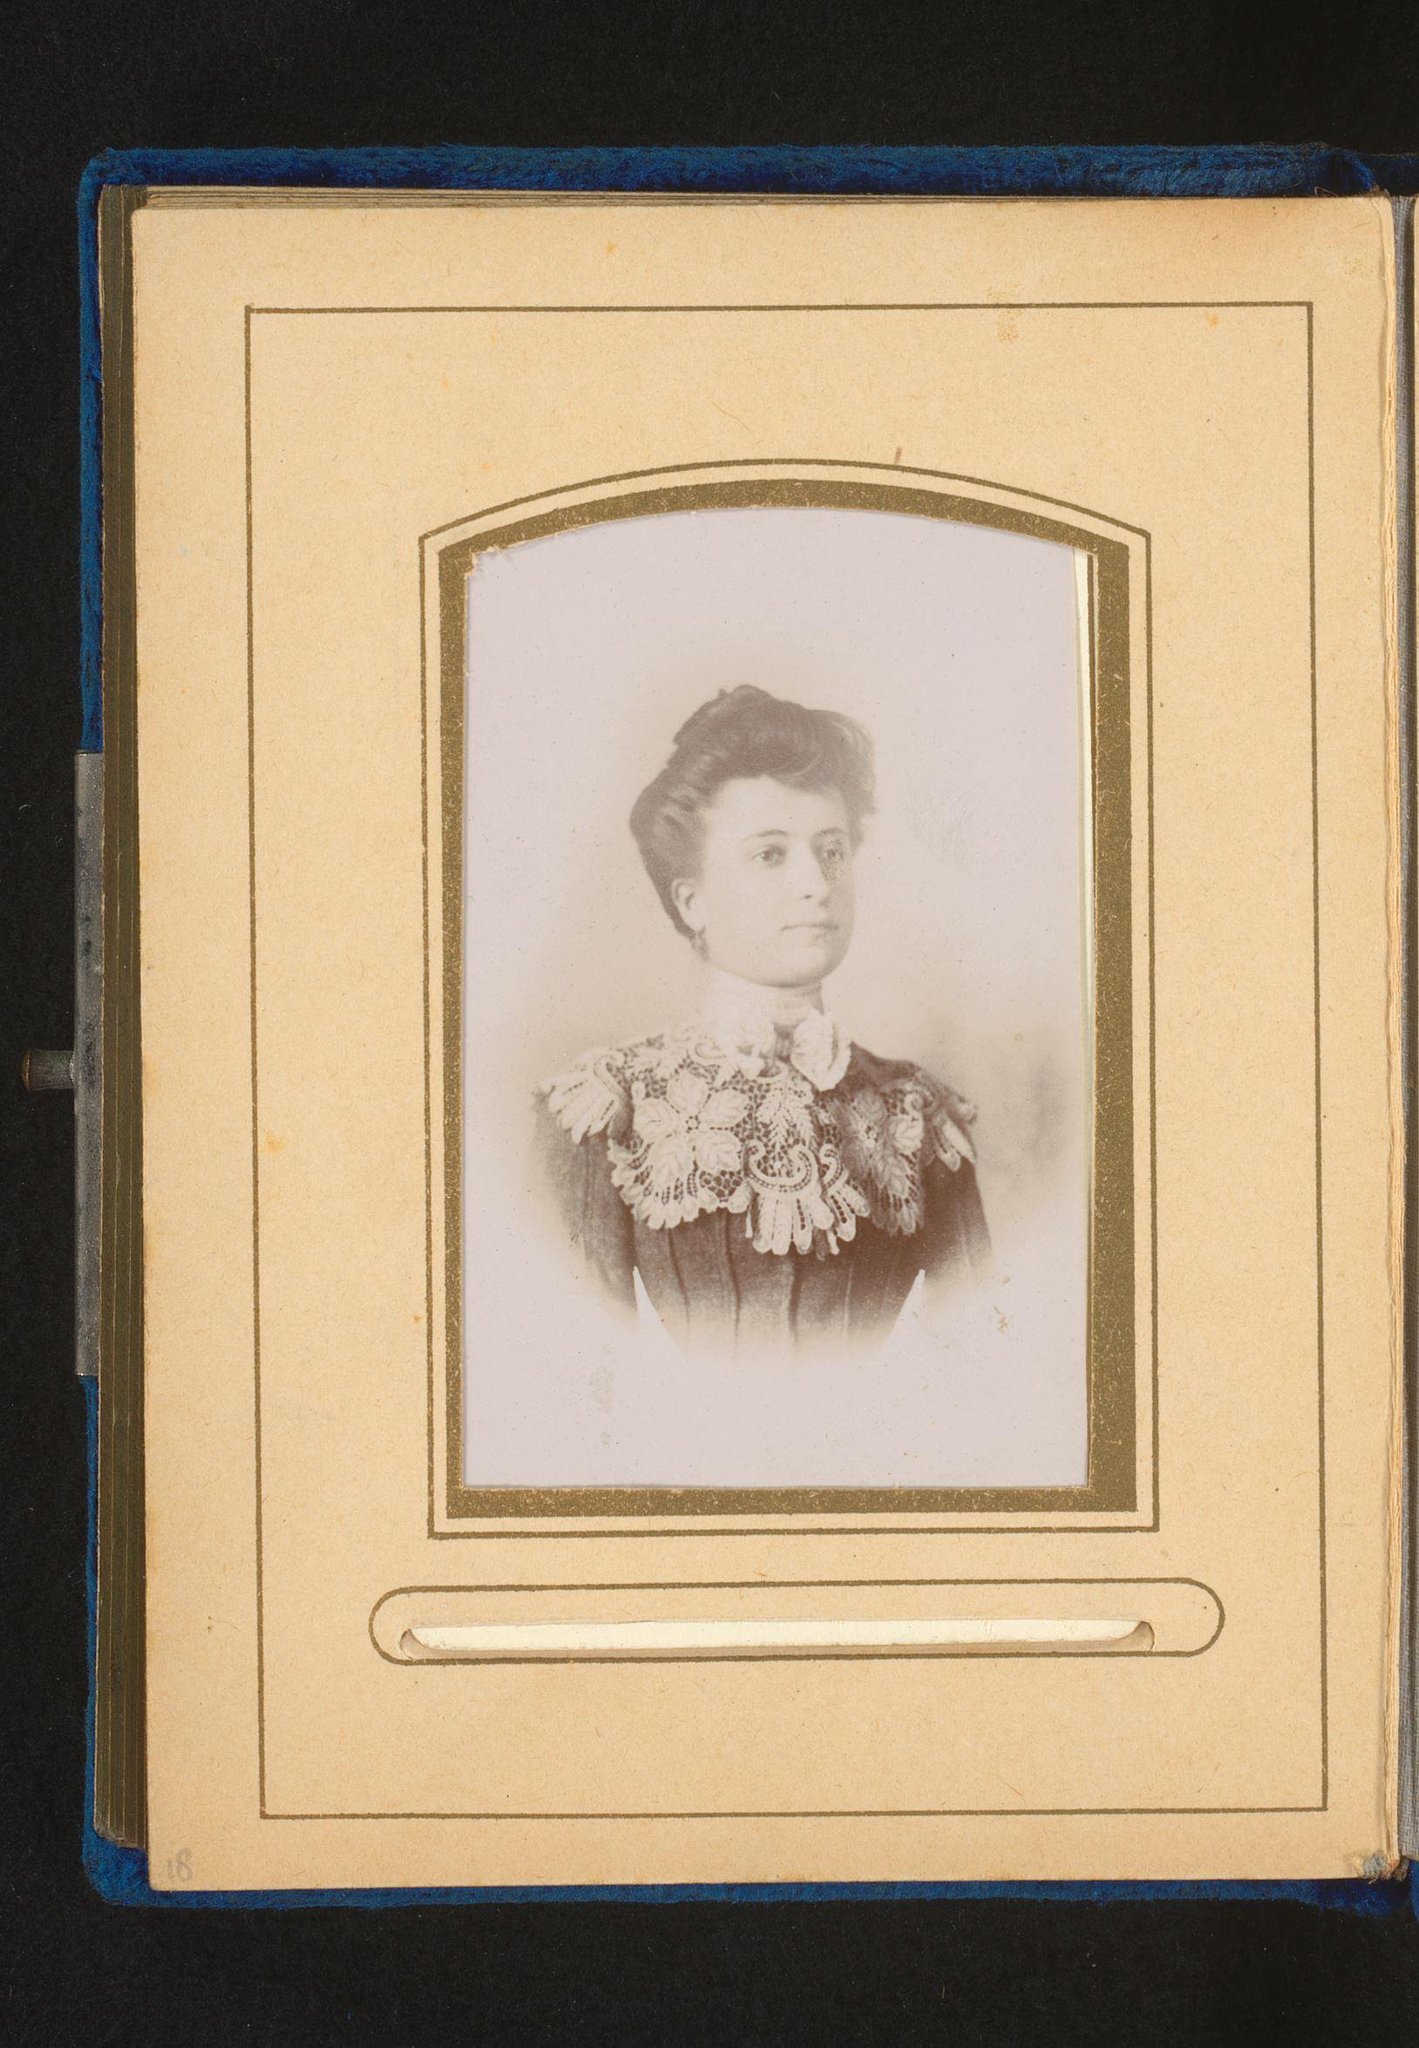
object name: carte de visite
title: Portret van een vrouw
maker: j. perallo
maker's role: fotograaf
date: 1882-1920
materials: cardboard, photographic support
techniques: gelatin silver print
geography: france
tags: historical persons - bb - woman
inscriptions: inscription: ‘J. Perallo R. REPUBLIQUE, 79’